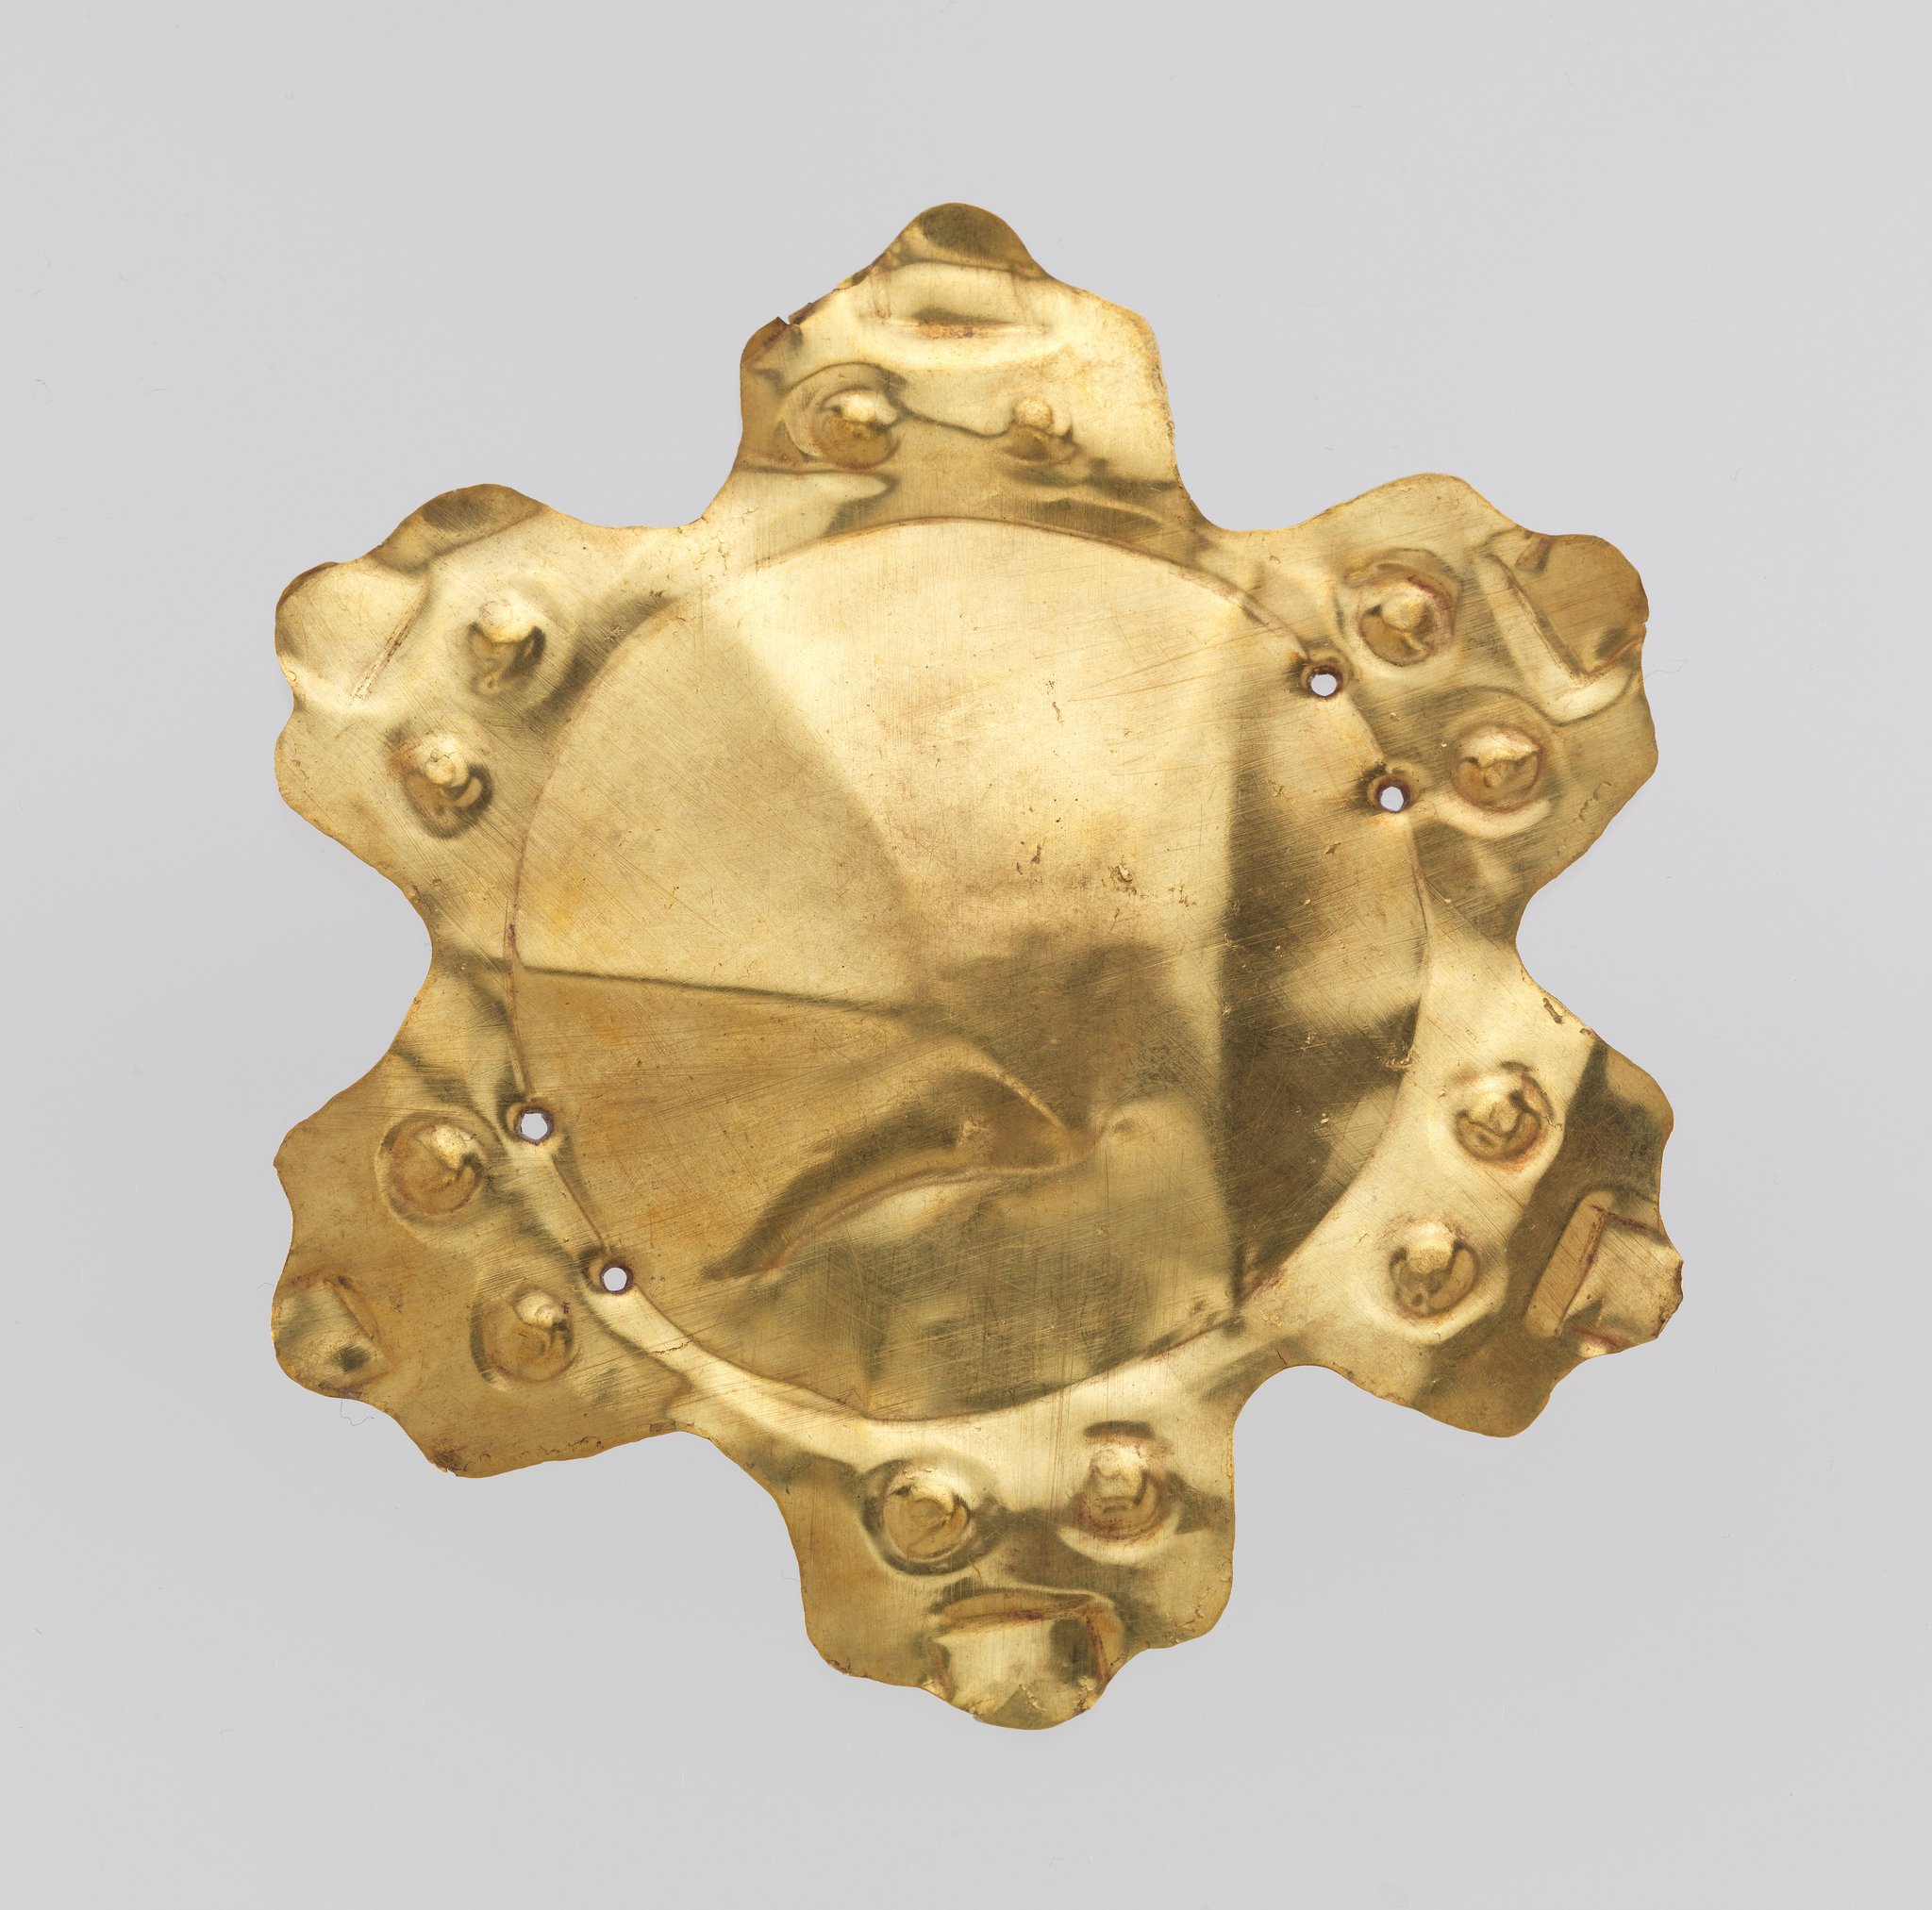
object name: ornament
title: Textile ornament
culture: nasca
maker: nasca artist(s)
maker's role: artist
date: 1-700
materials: gold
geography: peru